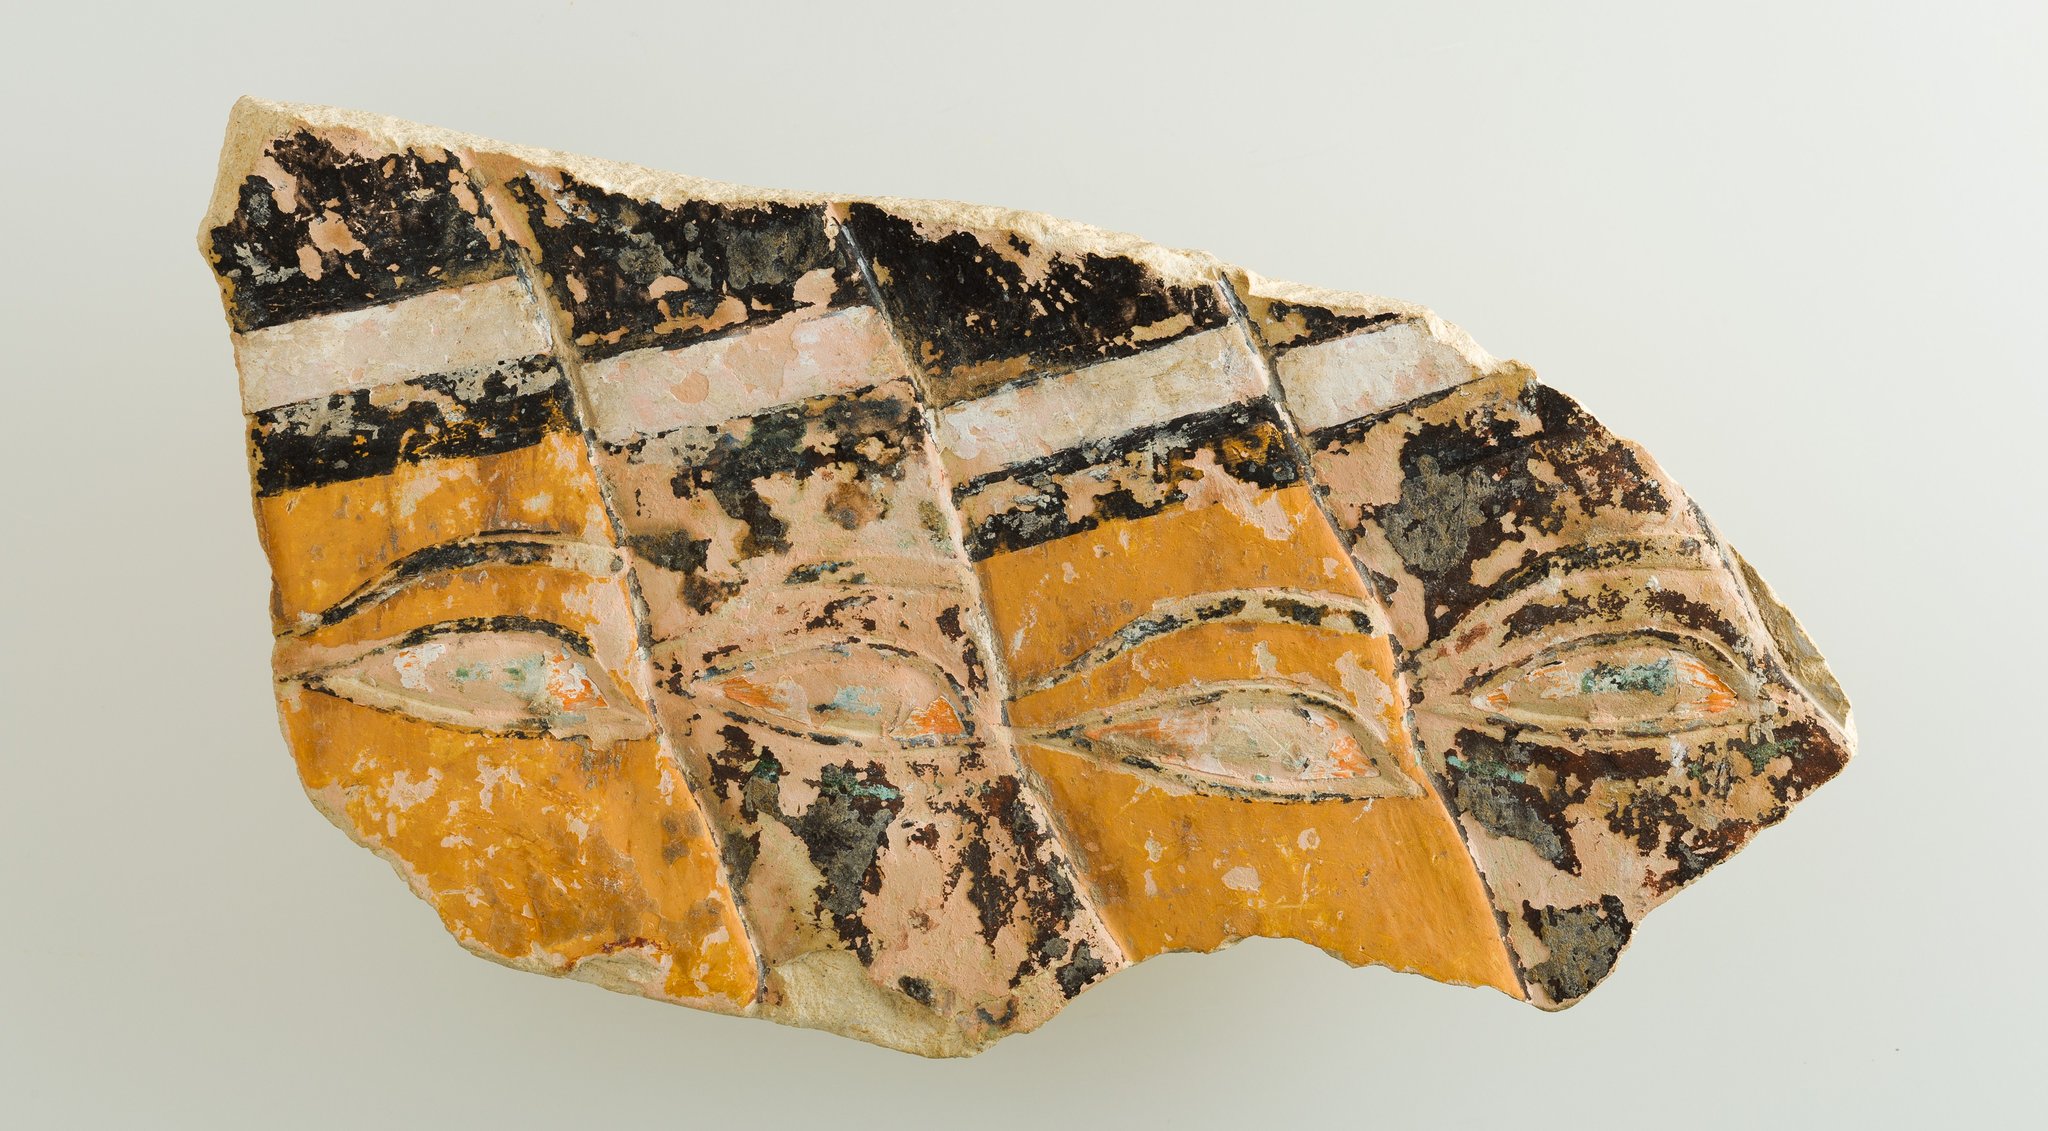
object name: relief, prisoners' head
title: Relief Fragment with Parts of Heads of Prisoners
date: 2030-2000 BCE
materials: limestone, paint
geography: egypt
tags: eyes